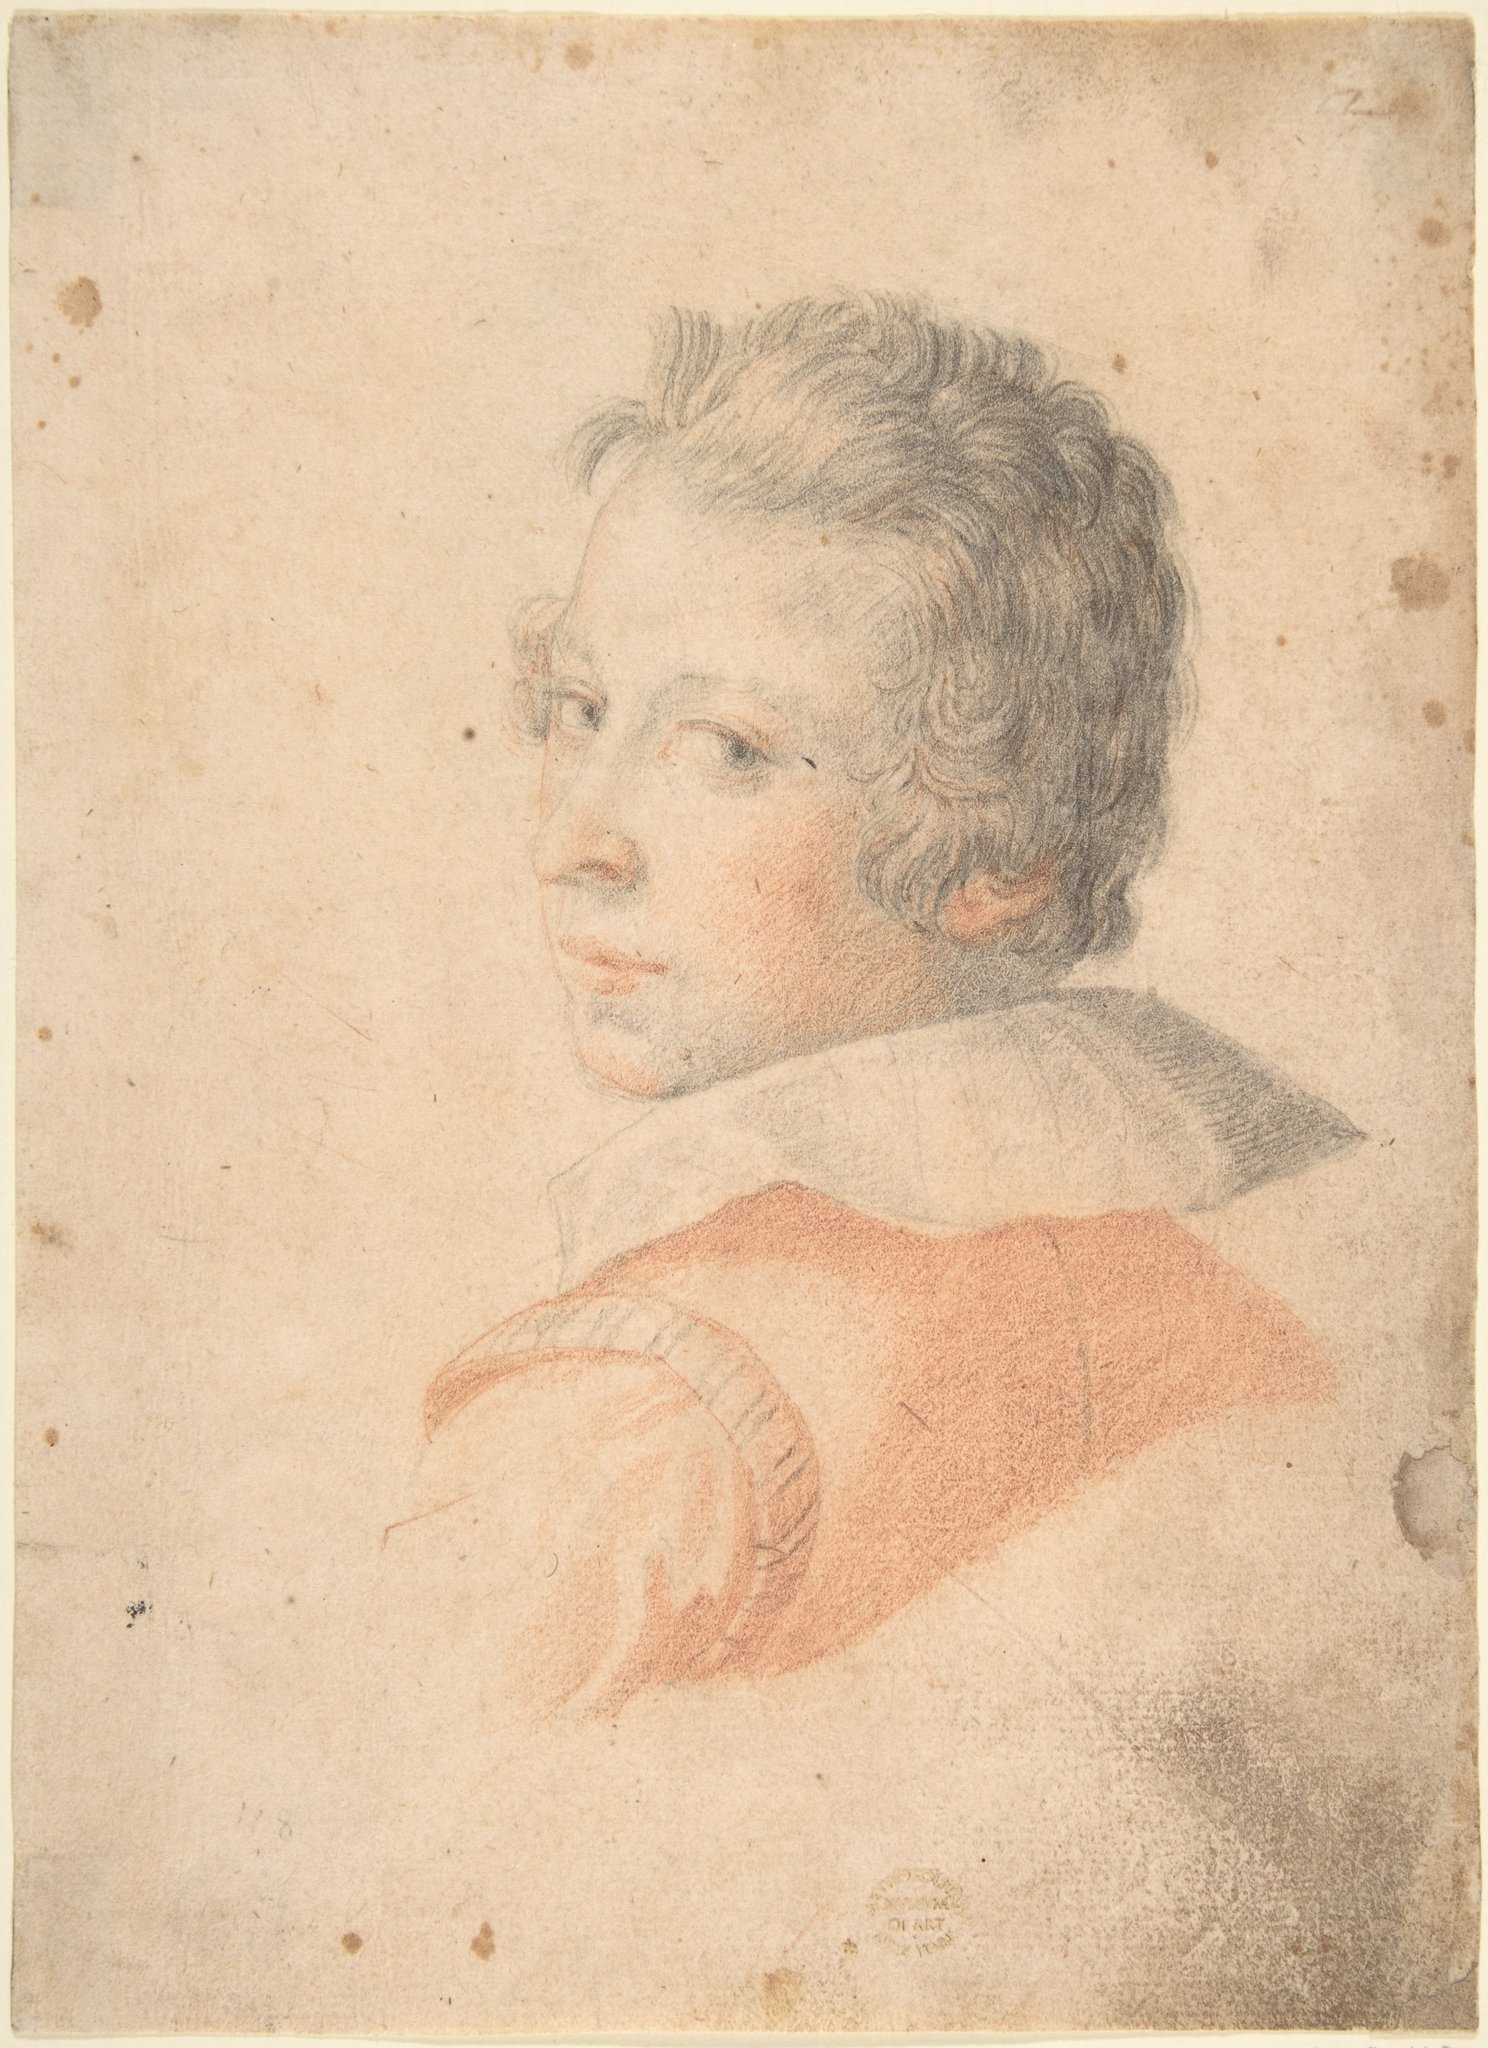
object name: drawing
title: Portrait of a Young Man in Three-Quarter View Looking over His Left Shoulder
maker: anonymous, italian, roman-bolognese, 17th century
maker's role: artist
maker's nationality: italian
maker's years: 1600-1700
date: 1601-1700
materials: chalk, paper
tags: men,portraits